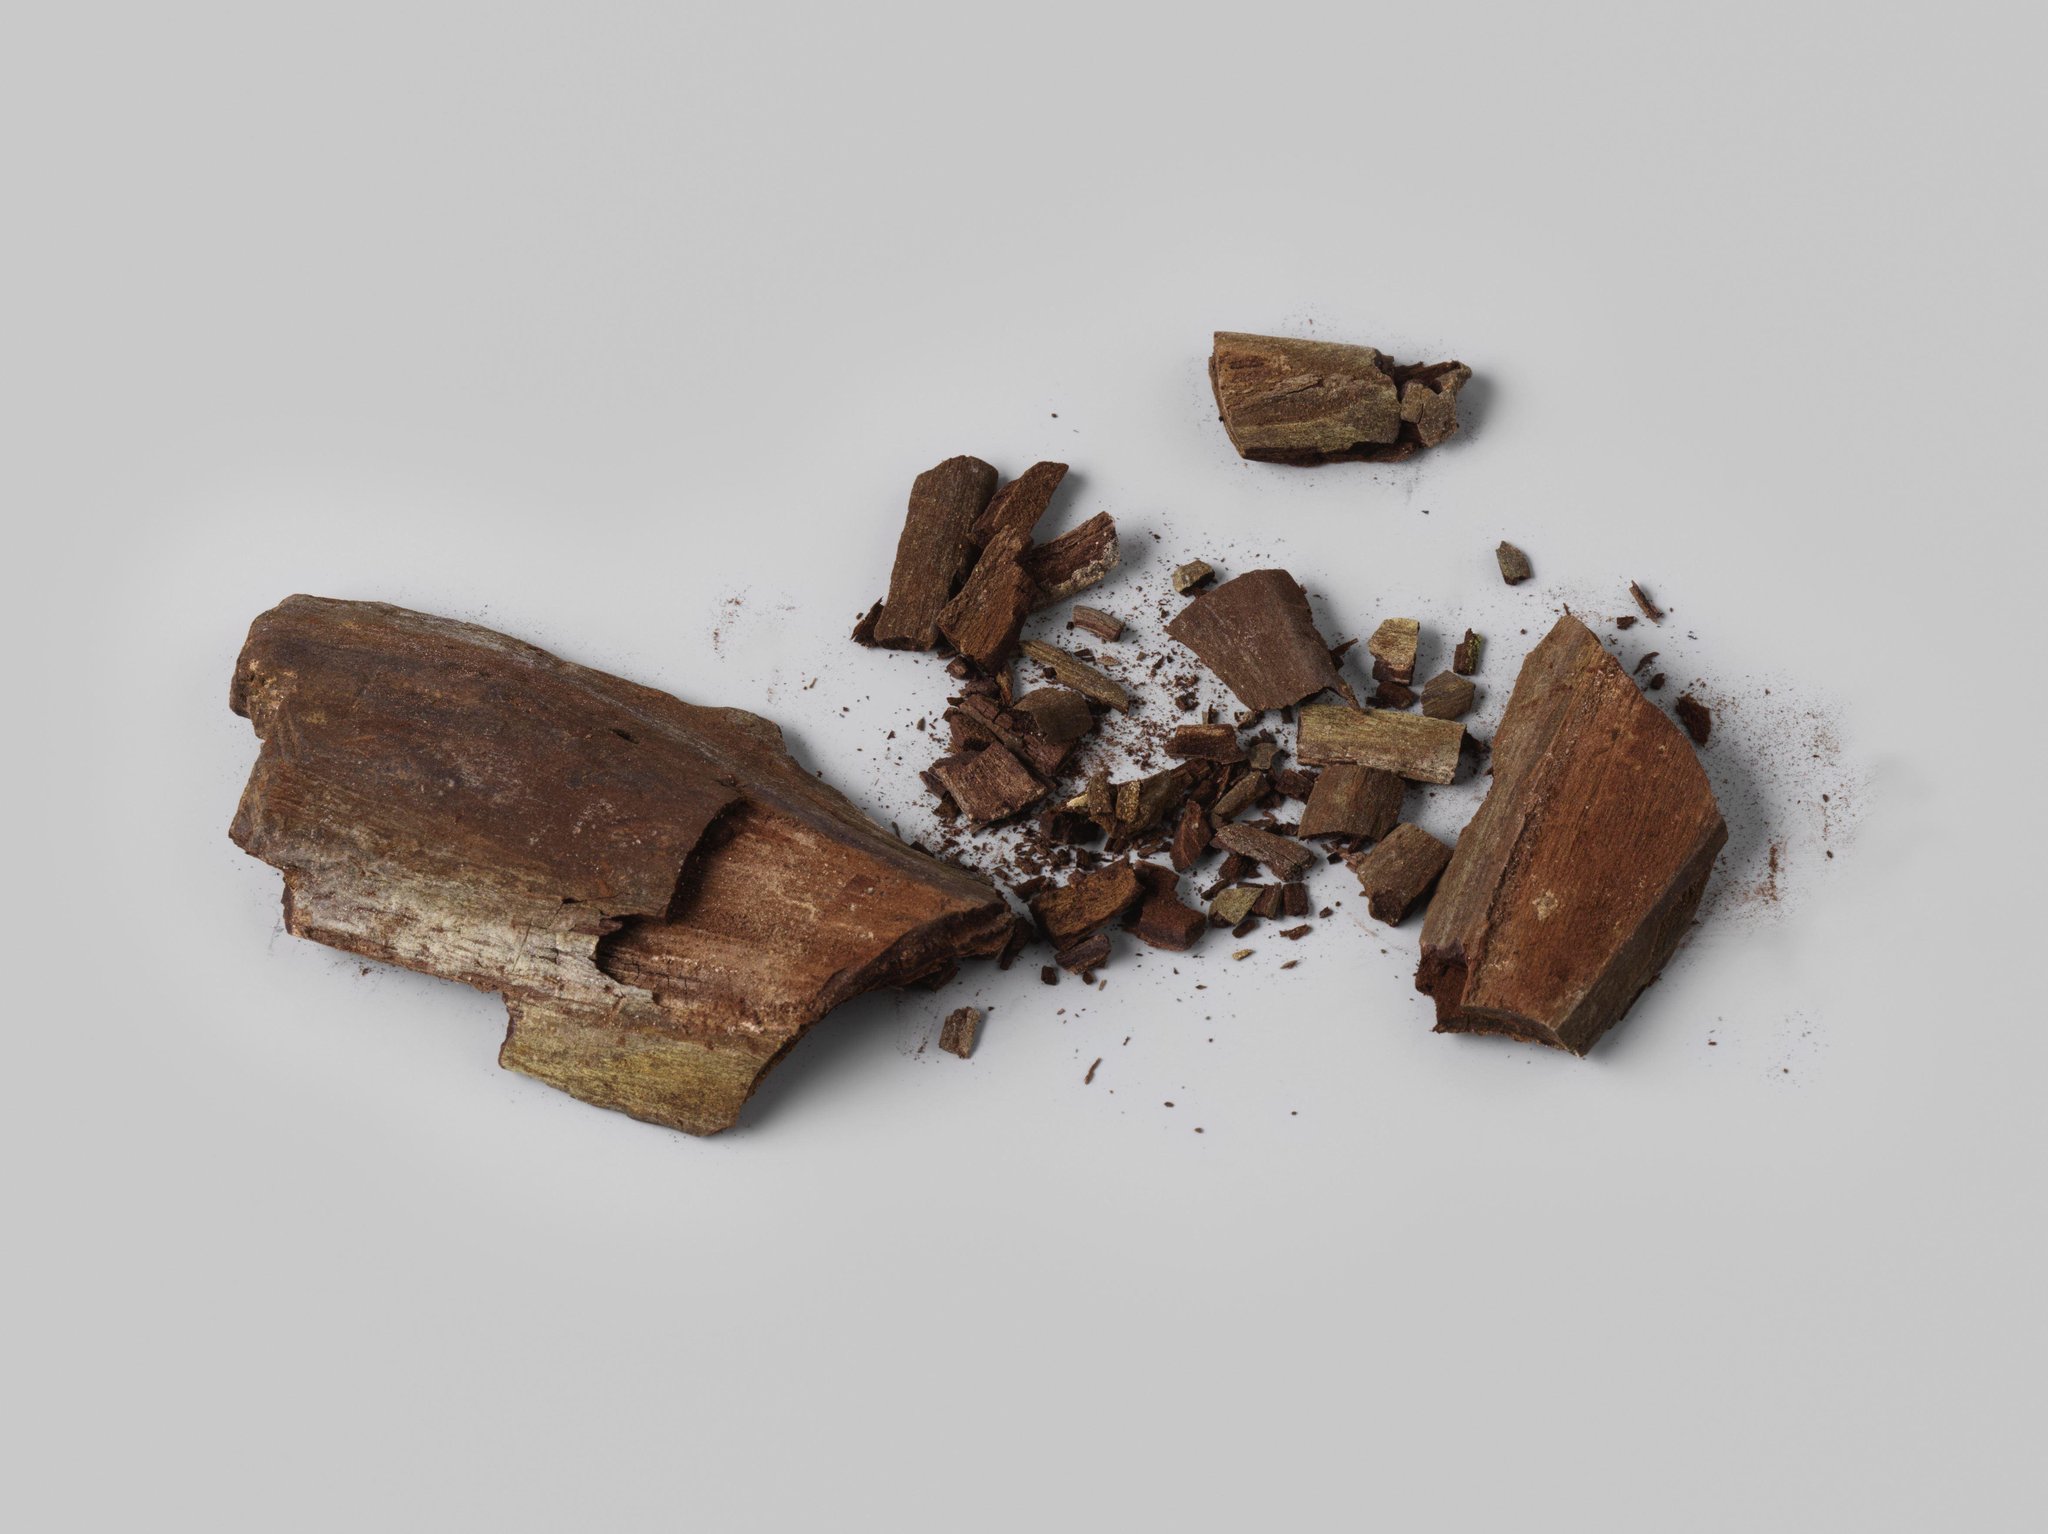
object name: fragment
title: Fragmenten en splinters hout uit het wrak van de Oost-Indiëvaarder Hollandia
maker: Anonymous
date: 1700-1743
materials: wood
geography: netherlands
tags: verenigde oostindische compagnie, hollandia (schip), annet